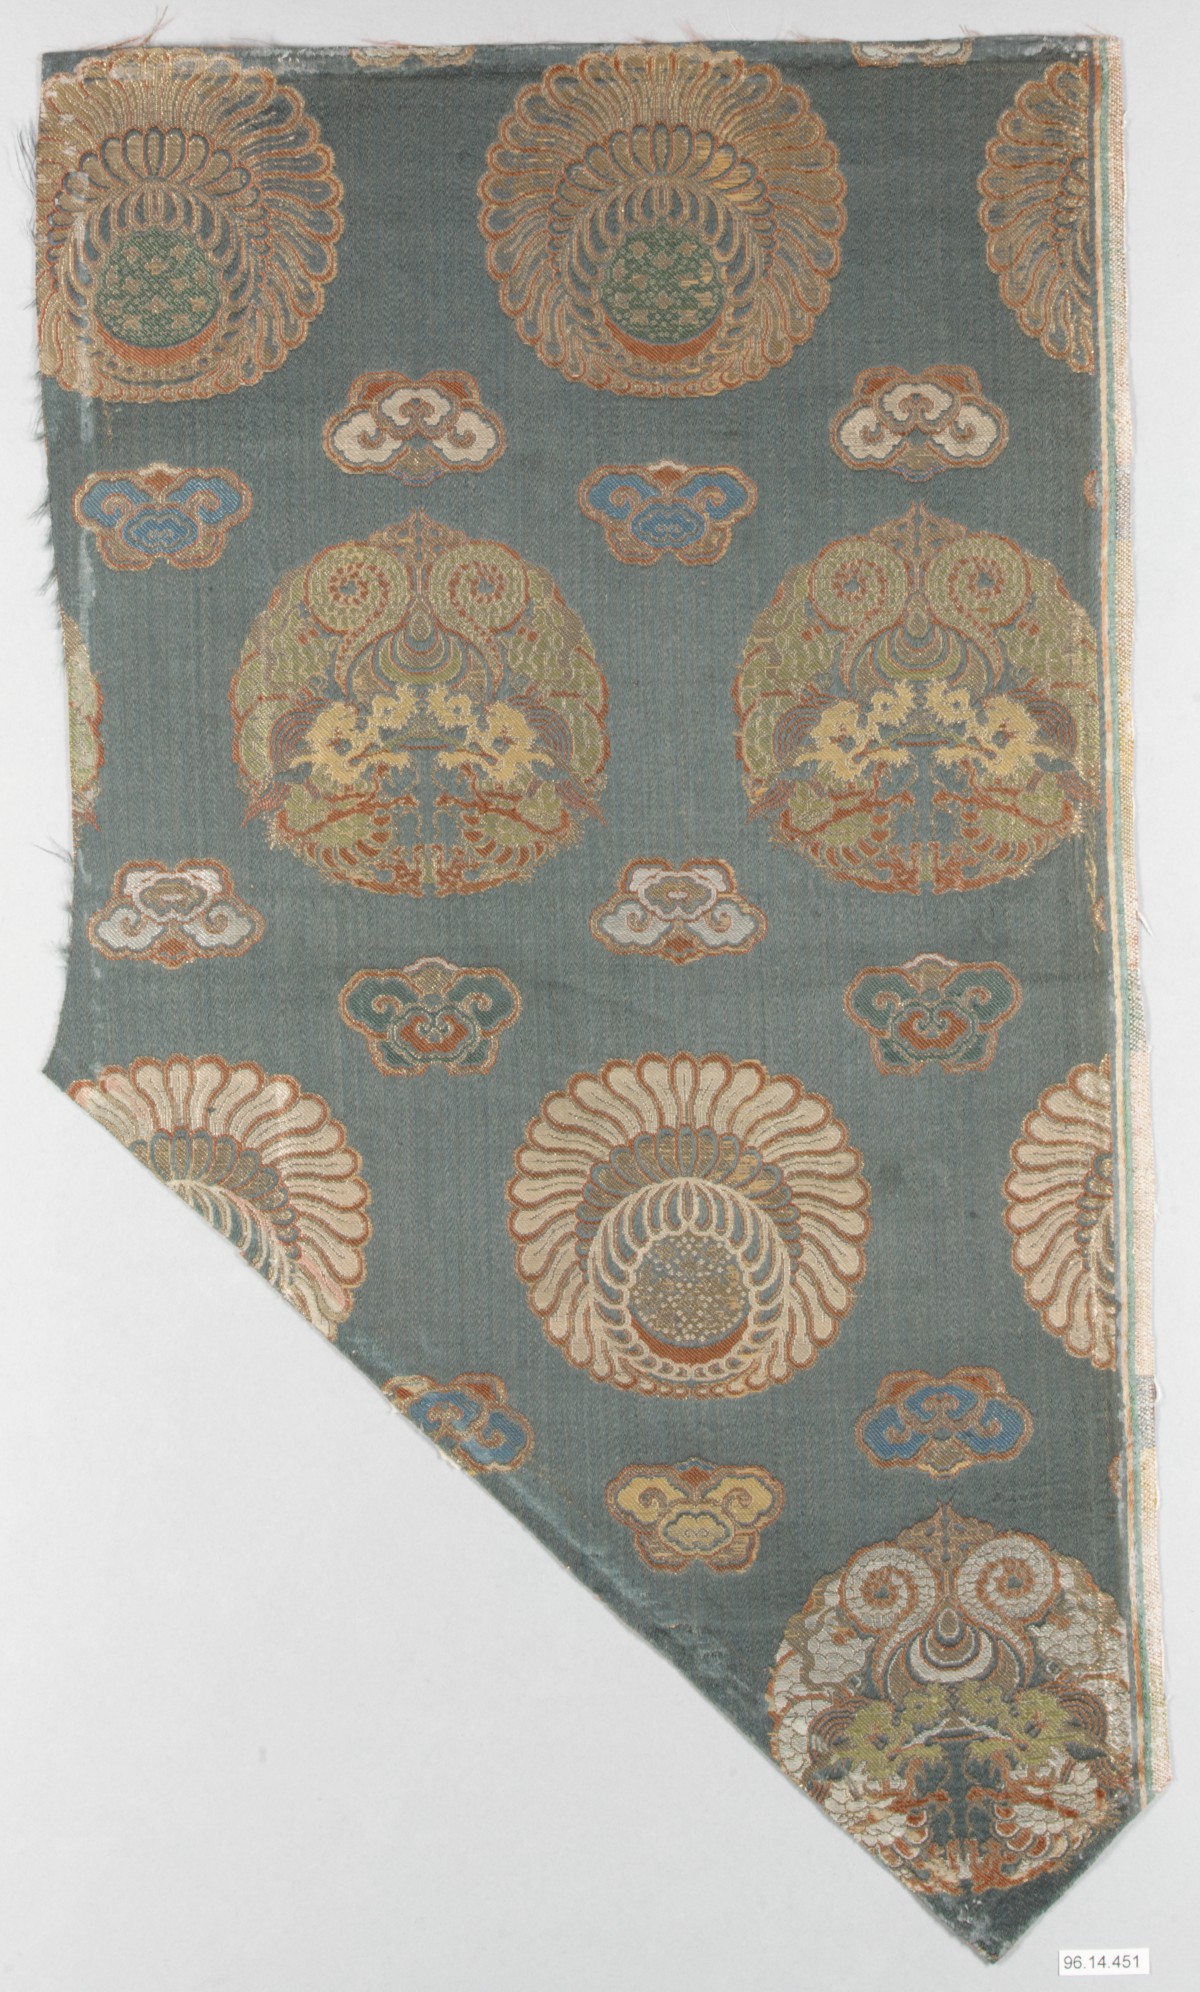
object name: piece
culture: japanese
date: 1701-1900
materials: silk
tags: dragons